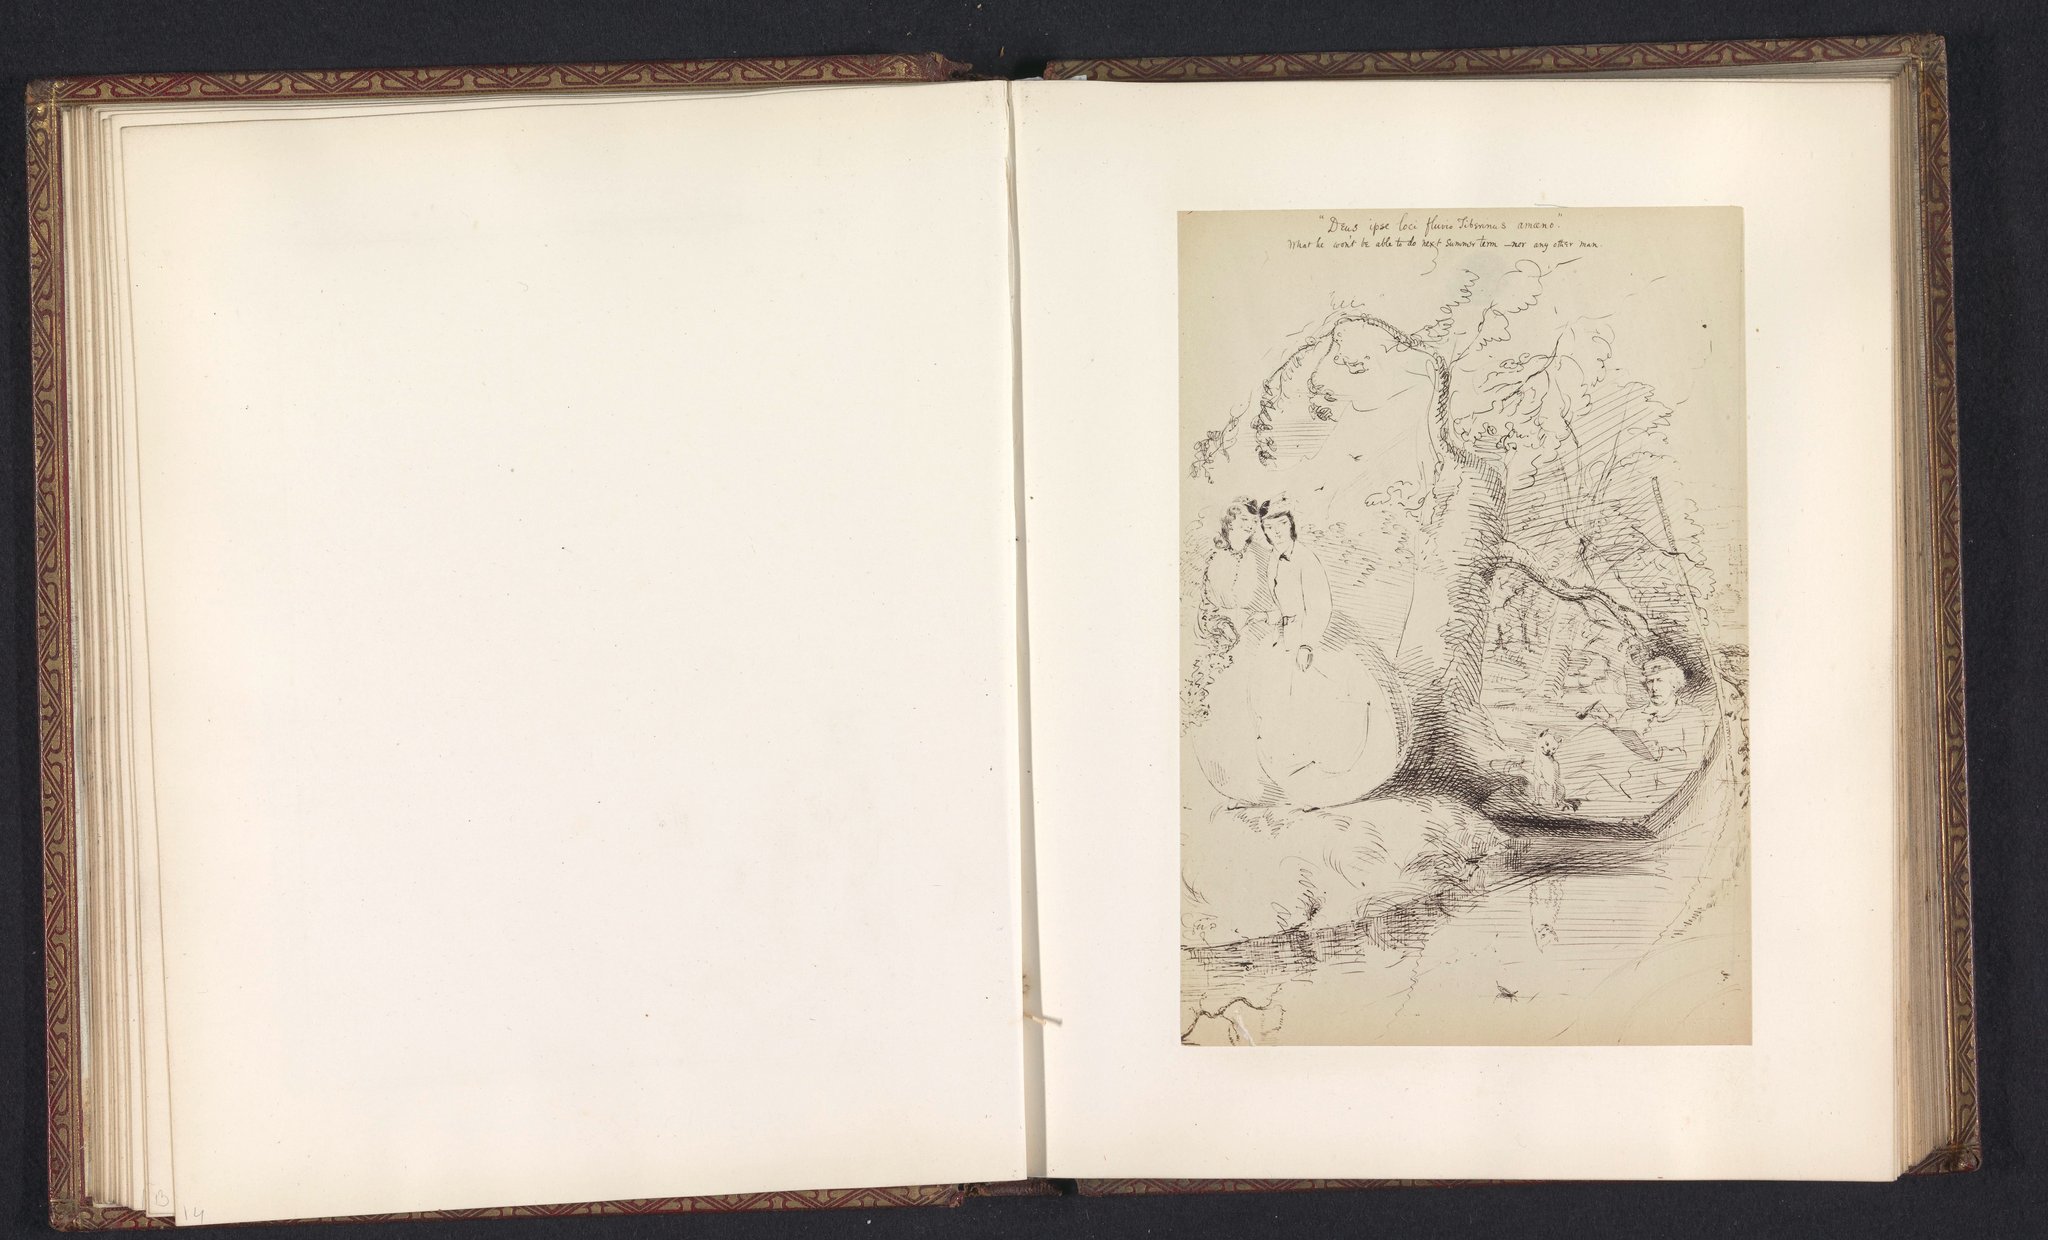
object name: page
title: Fotoreproductie van een tekening, voorstellende de decaan van Cherwell College in een boot langs de Cherwell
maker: Anonymous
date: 1855-1866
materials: photographic support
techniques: albumen print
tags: caricatures (human types), river, rowing-boat, canoe, etc., student life